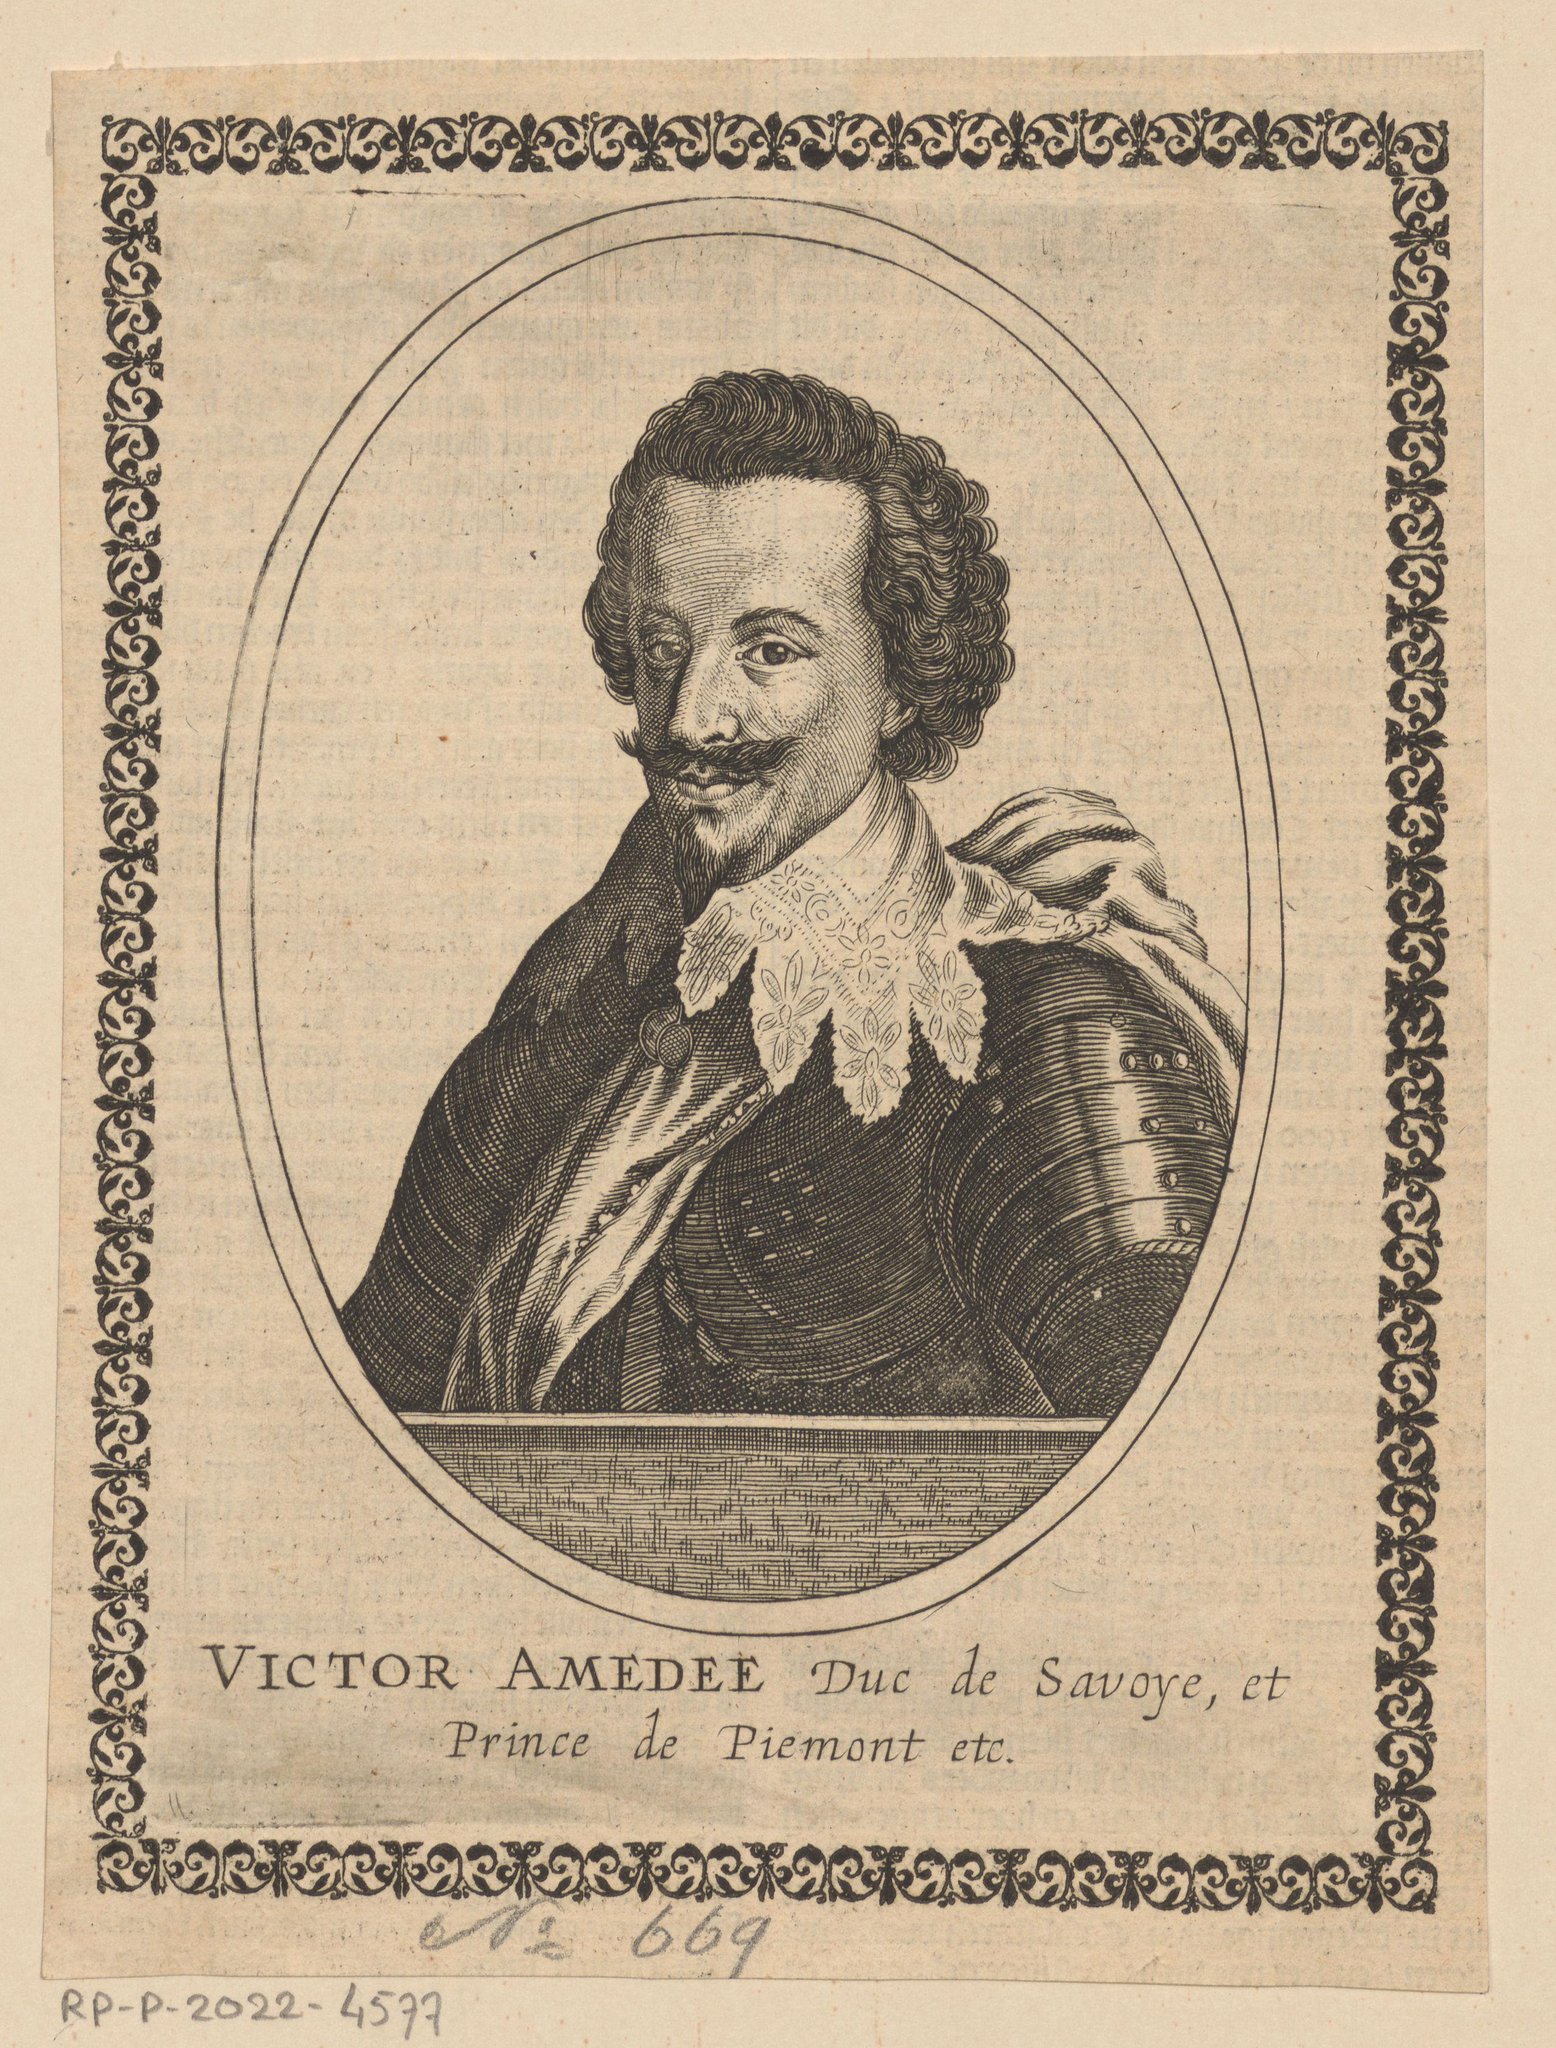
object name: book illustration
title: Portret van Victor Amadeus I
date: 1642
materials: paper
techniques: engraving, etching, letterpress printing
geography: amsterdam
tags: historical persons, ruler, sovereign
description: Prent uit: Abelin, Johann Philipp. Historis oft waerachtich verhael van den gantschen toestant van oorlooge, soo die ghevoert is in Duytschlandt (...). Amsterdam: Cornelis Danckerts, 1642, p. 114.